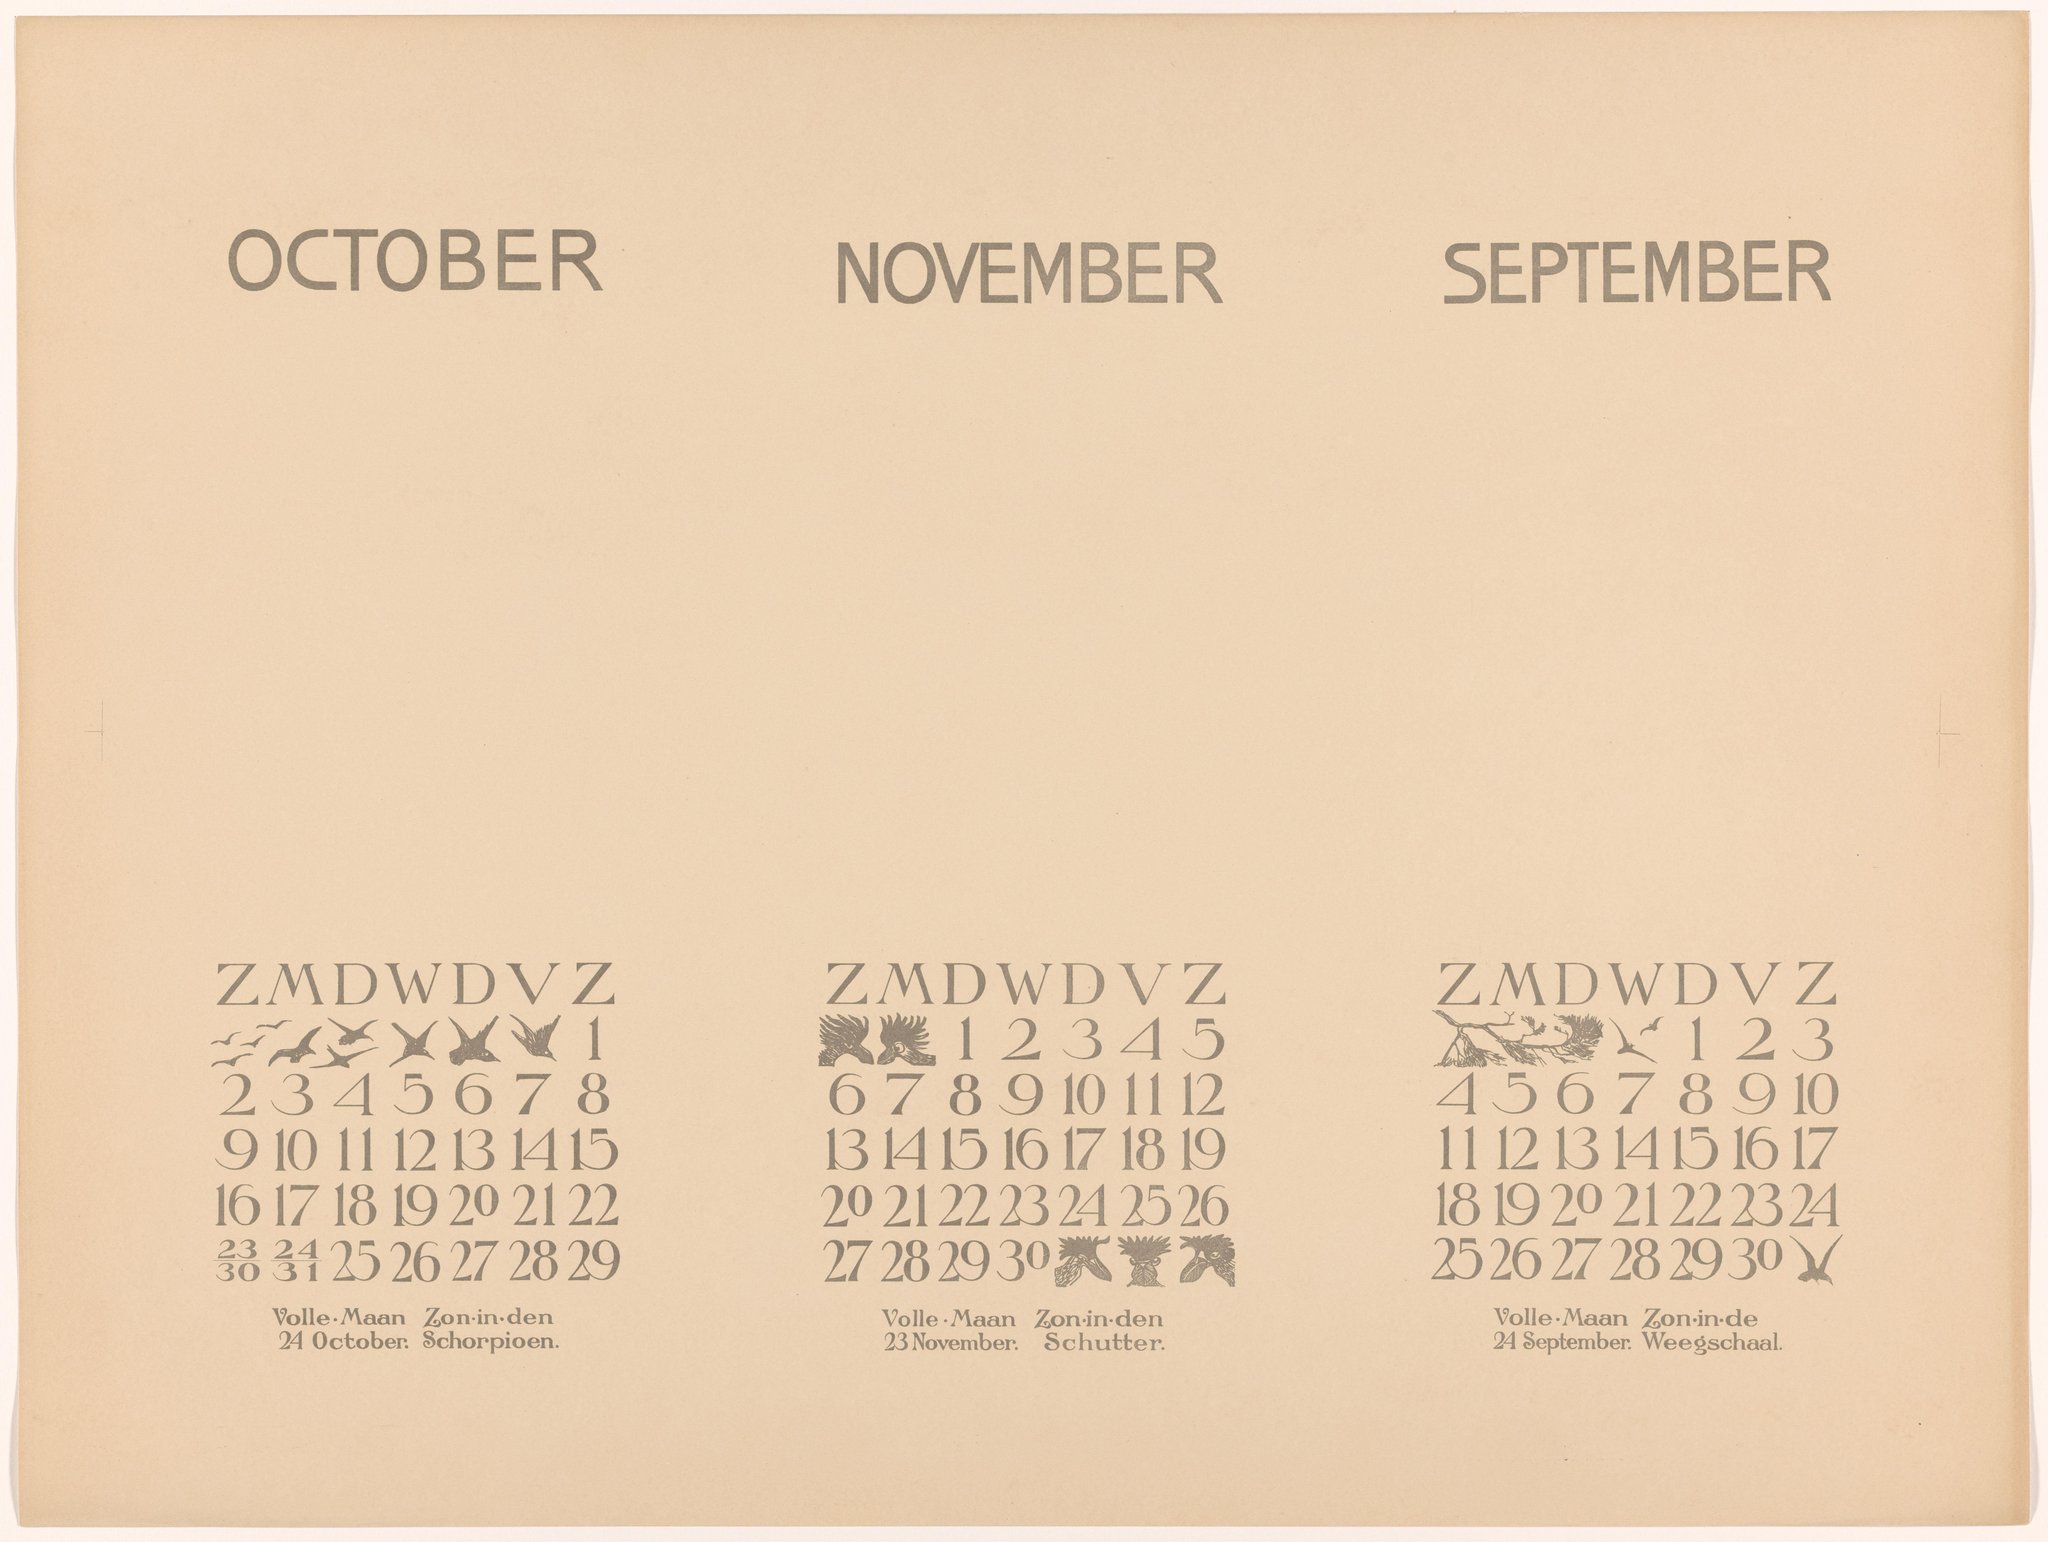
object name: print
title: Kalenders voor oktober, november en september 1904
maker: theo van hoytema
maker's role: draughtsman, painter, print maker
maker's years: 1863-1917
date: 1904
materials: paper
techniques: lithograph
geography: amsterdam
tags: predatory birds: falcon, calendar, almanac, shore-birds and wading-birds: heron, groups of birds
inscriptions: collector's mark: Lugt 2233